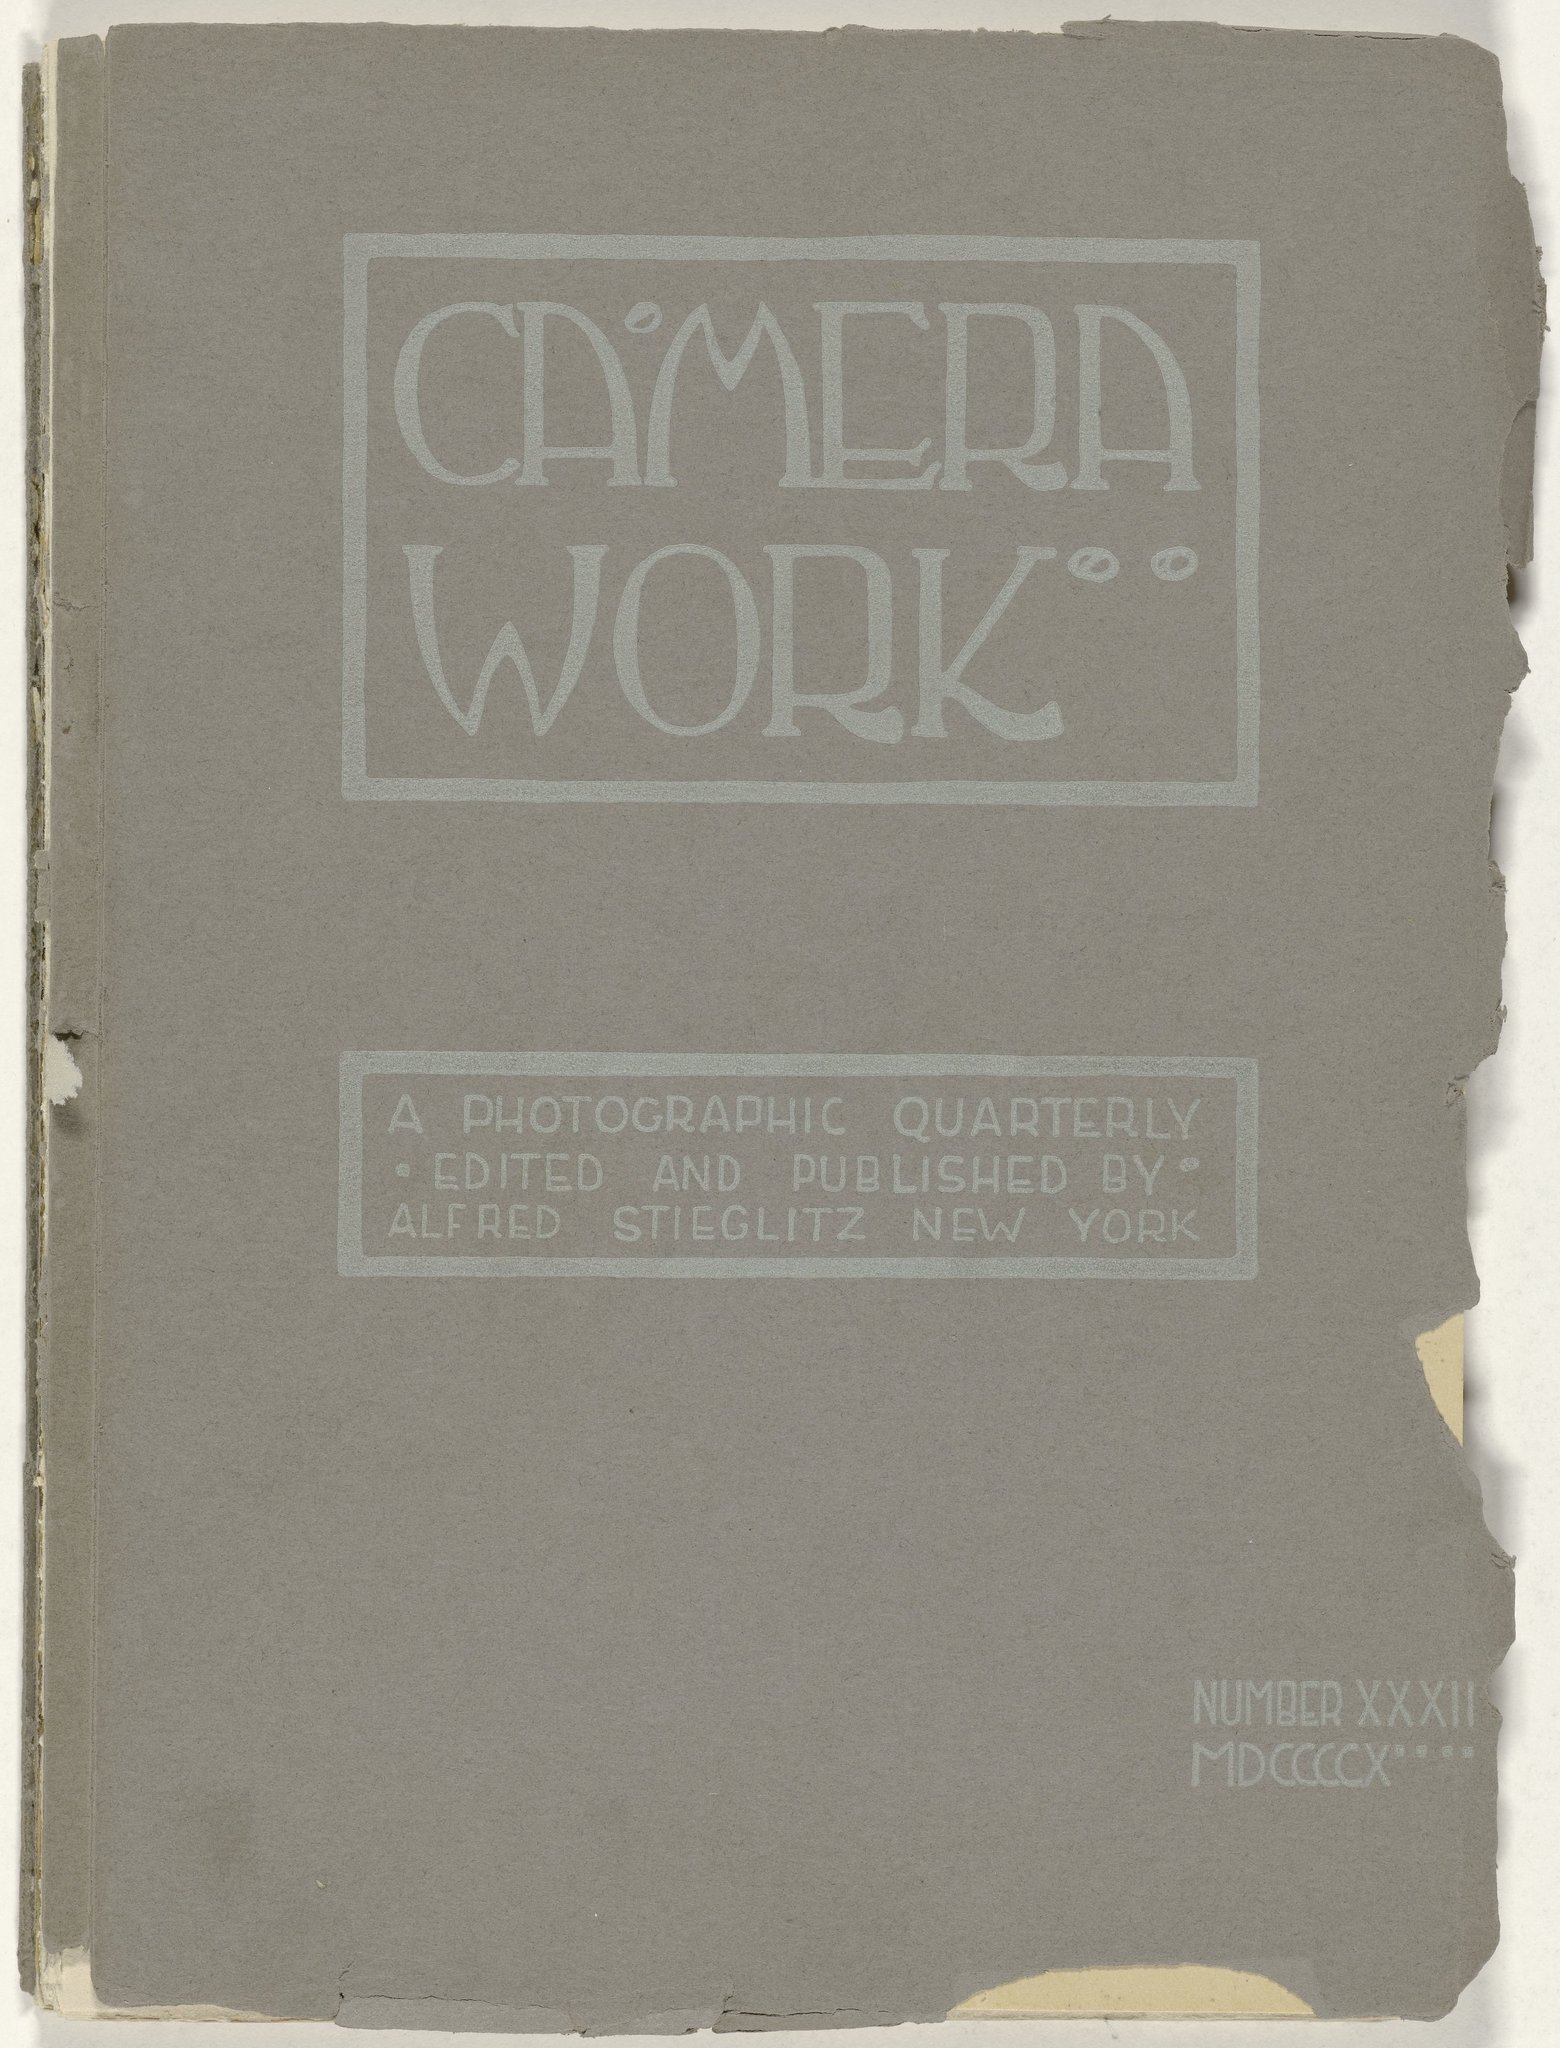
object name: magazine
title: Camera Work. A photographic Quarterly. Edited and published by Alfred Stieglitz New York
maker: alfred stieglitz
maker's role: fotograaf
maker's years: 1864-1946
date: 1910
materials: cardboard, paper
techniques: letterpress printing, photoaquatint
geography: new york city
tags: photography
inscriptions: inscription: ‘EASTMAN/ ES/ PLATINUM/ In this paper we offer a sepia platinum of highest quality -/ a new hot bath sepia, rich in tone and printing quality - a pure/ platinum paper coated on buff stock in two surfaces - smooth/ and rough./ EASTMAN KODAK CO.,/ Rochester, N.Y.’, date: ‘NUMBER XXXII/ MDCCCCX’, title: ‘CAMERA/ WORK/ A PHOTOGRAPHIC QUARTERLY/ EDITED AND PUBLISHED BY/ ALFRED STIEGLITZ NEW YORK’